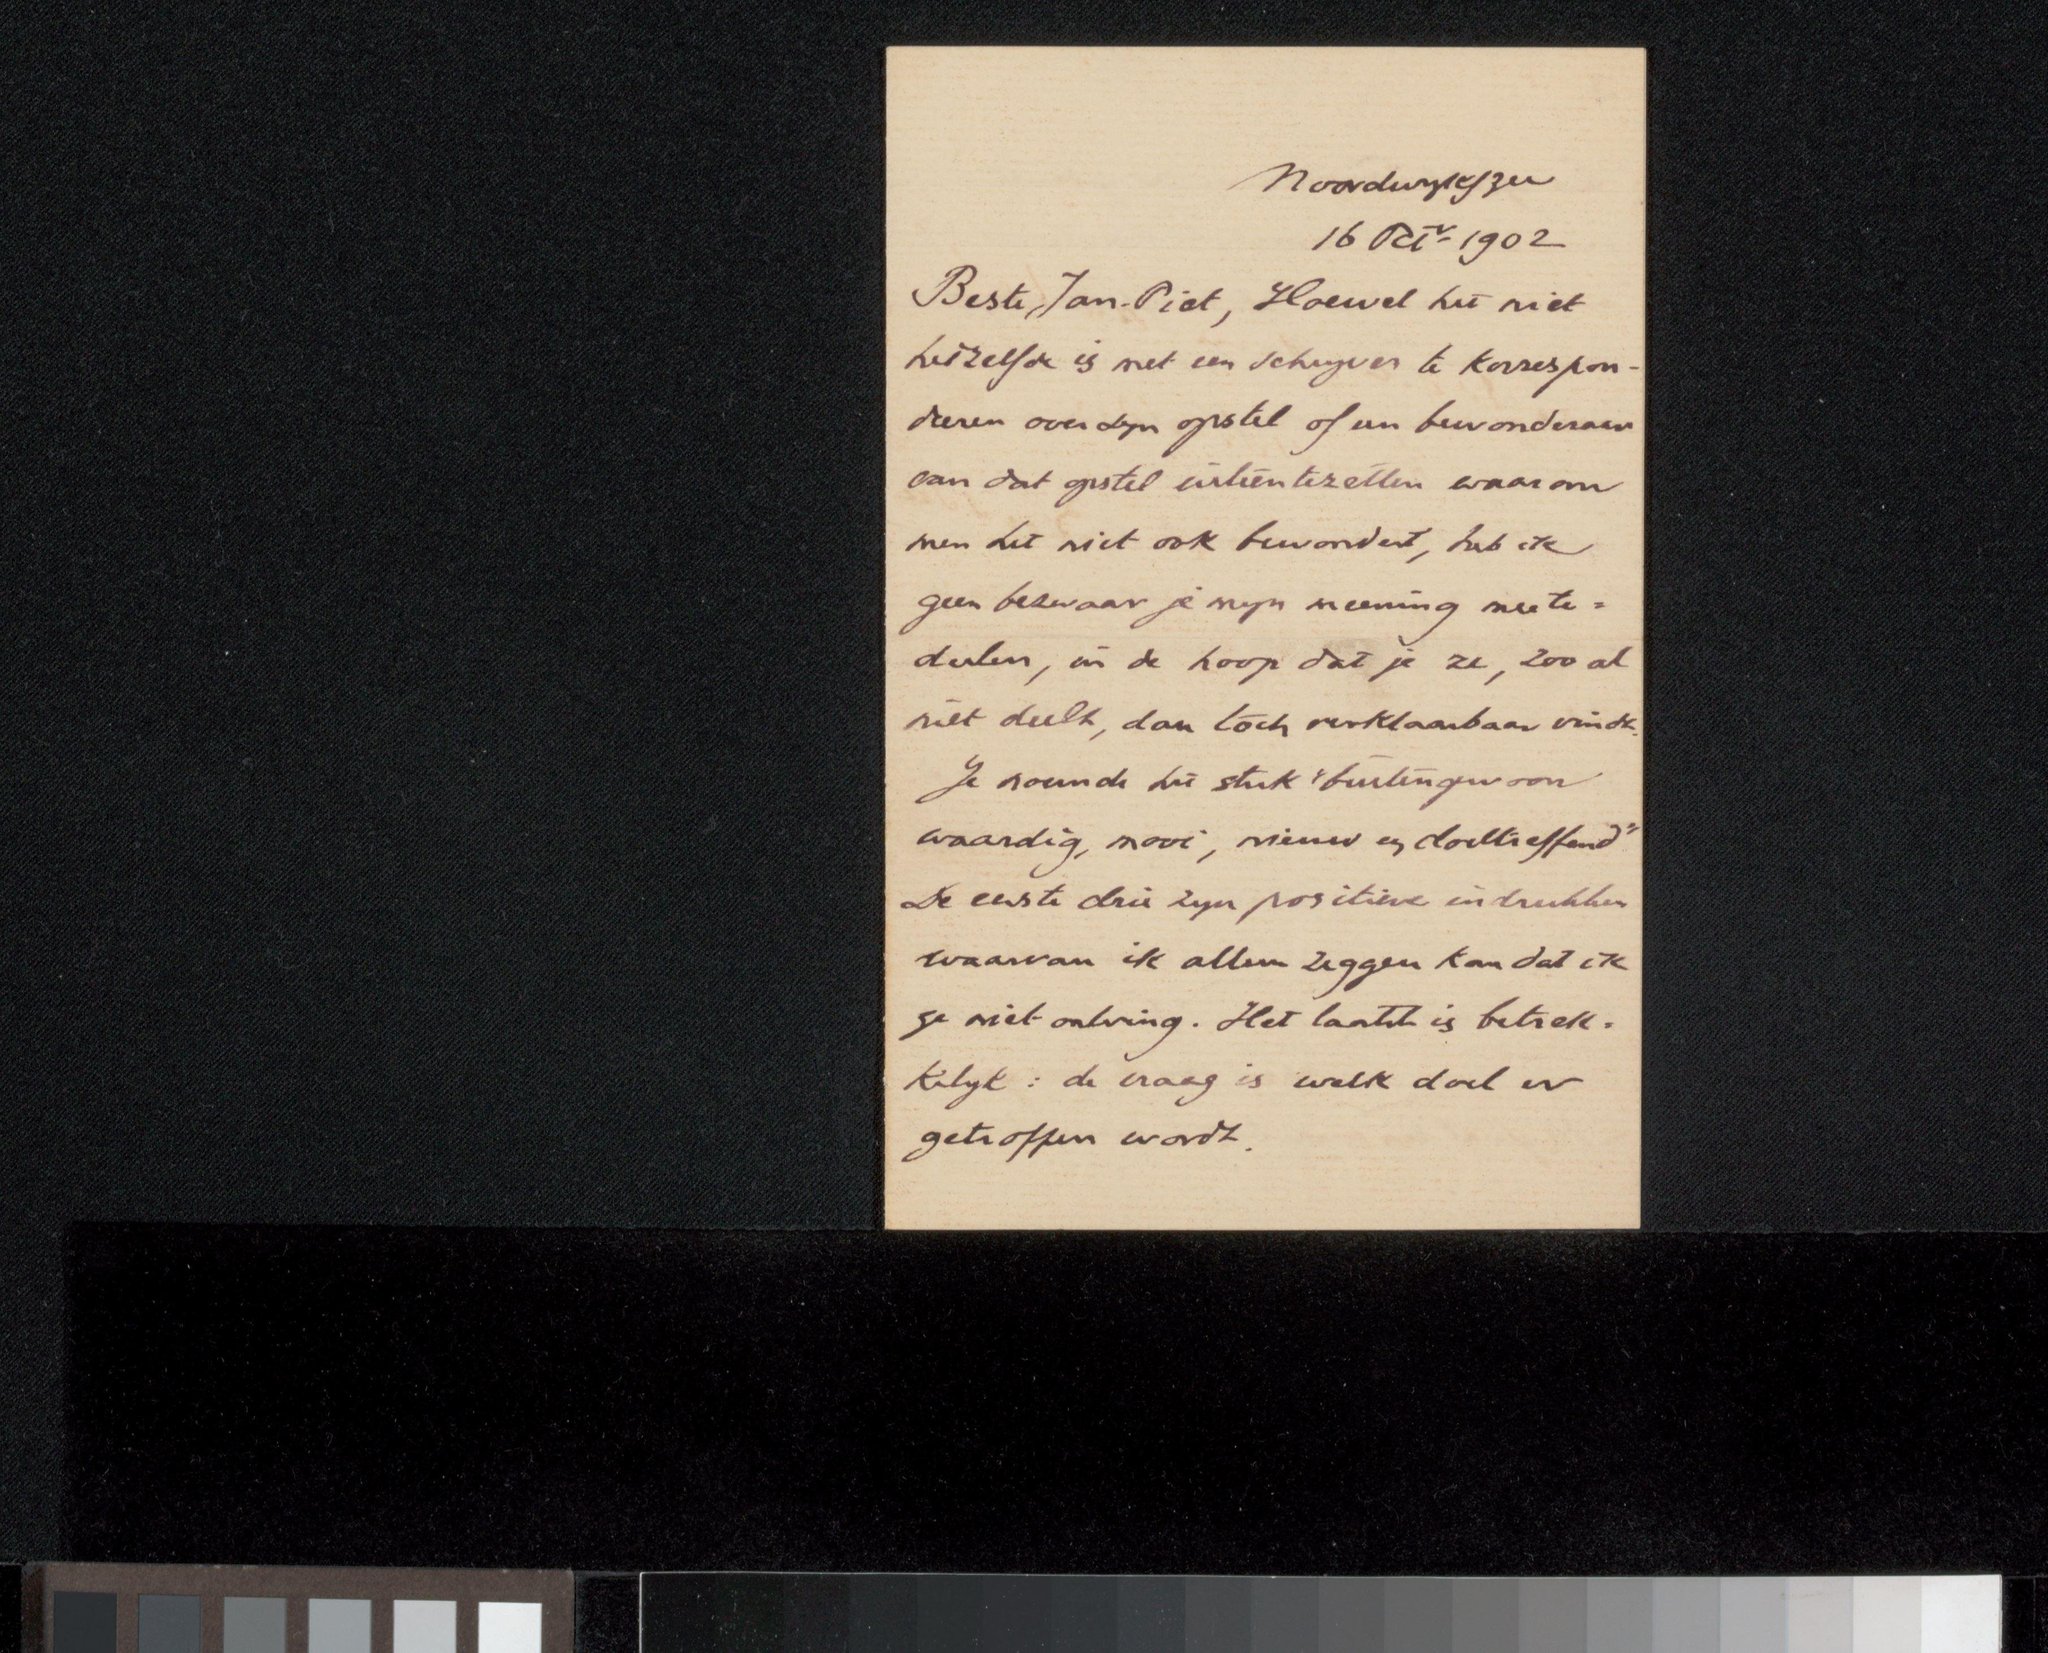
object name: letter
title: Brief aan Jan Veth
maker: albert verwey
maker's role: criticus, dichter, essayist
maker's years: 1865-1937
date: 1902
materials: ink, paper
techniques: pen, writing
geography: noordwijk aan zee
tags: painter, print maker, draughtsman, jan veth, gerrit willem dijsselhof, passions, emotions, affections, literature ~ arts, exhibition ~ art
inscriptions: collector's mark: ‘RPK’